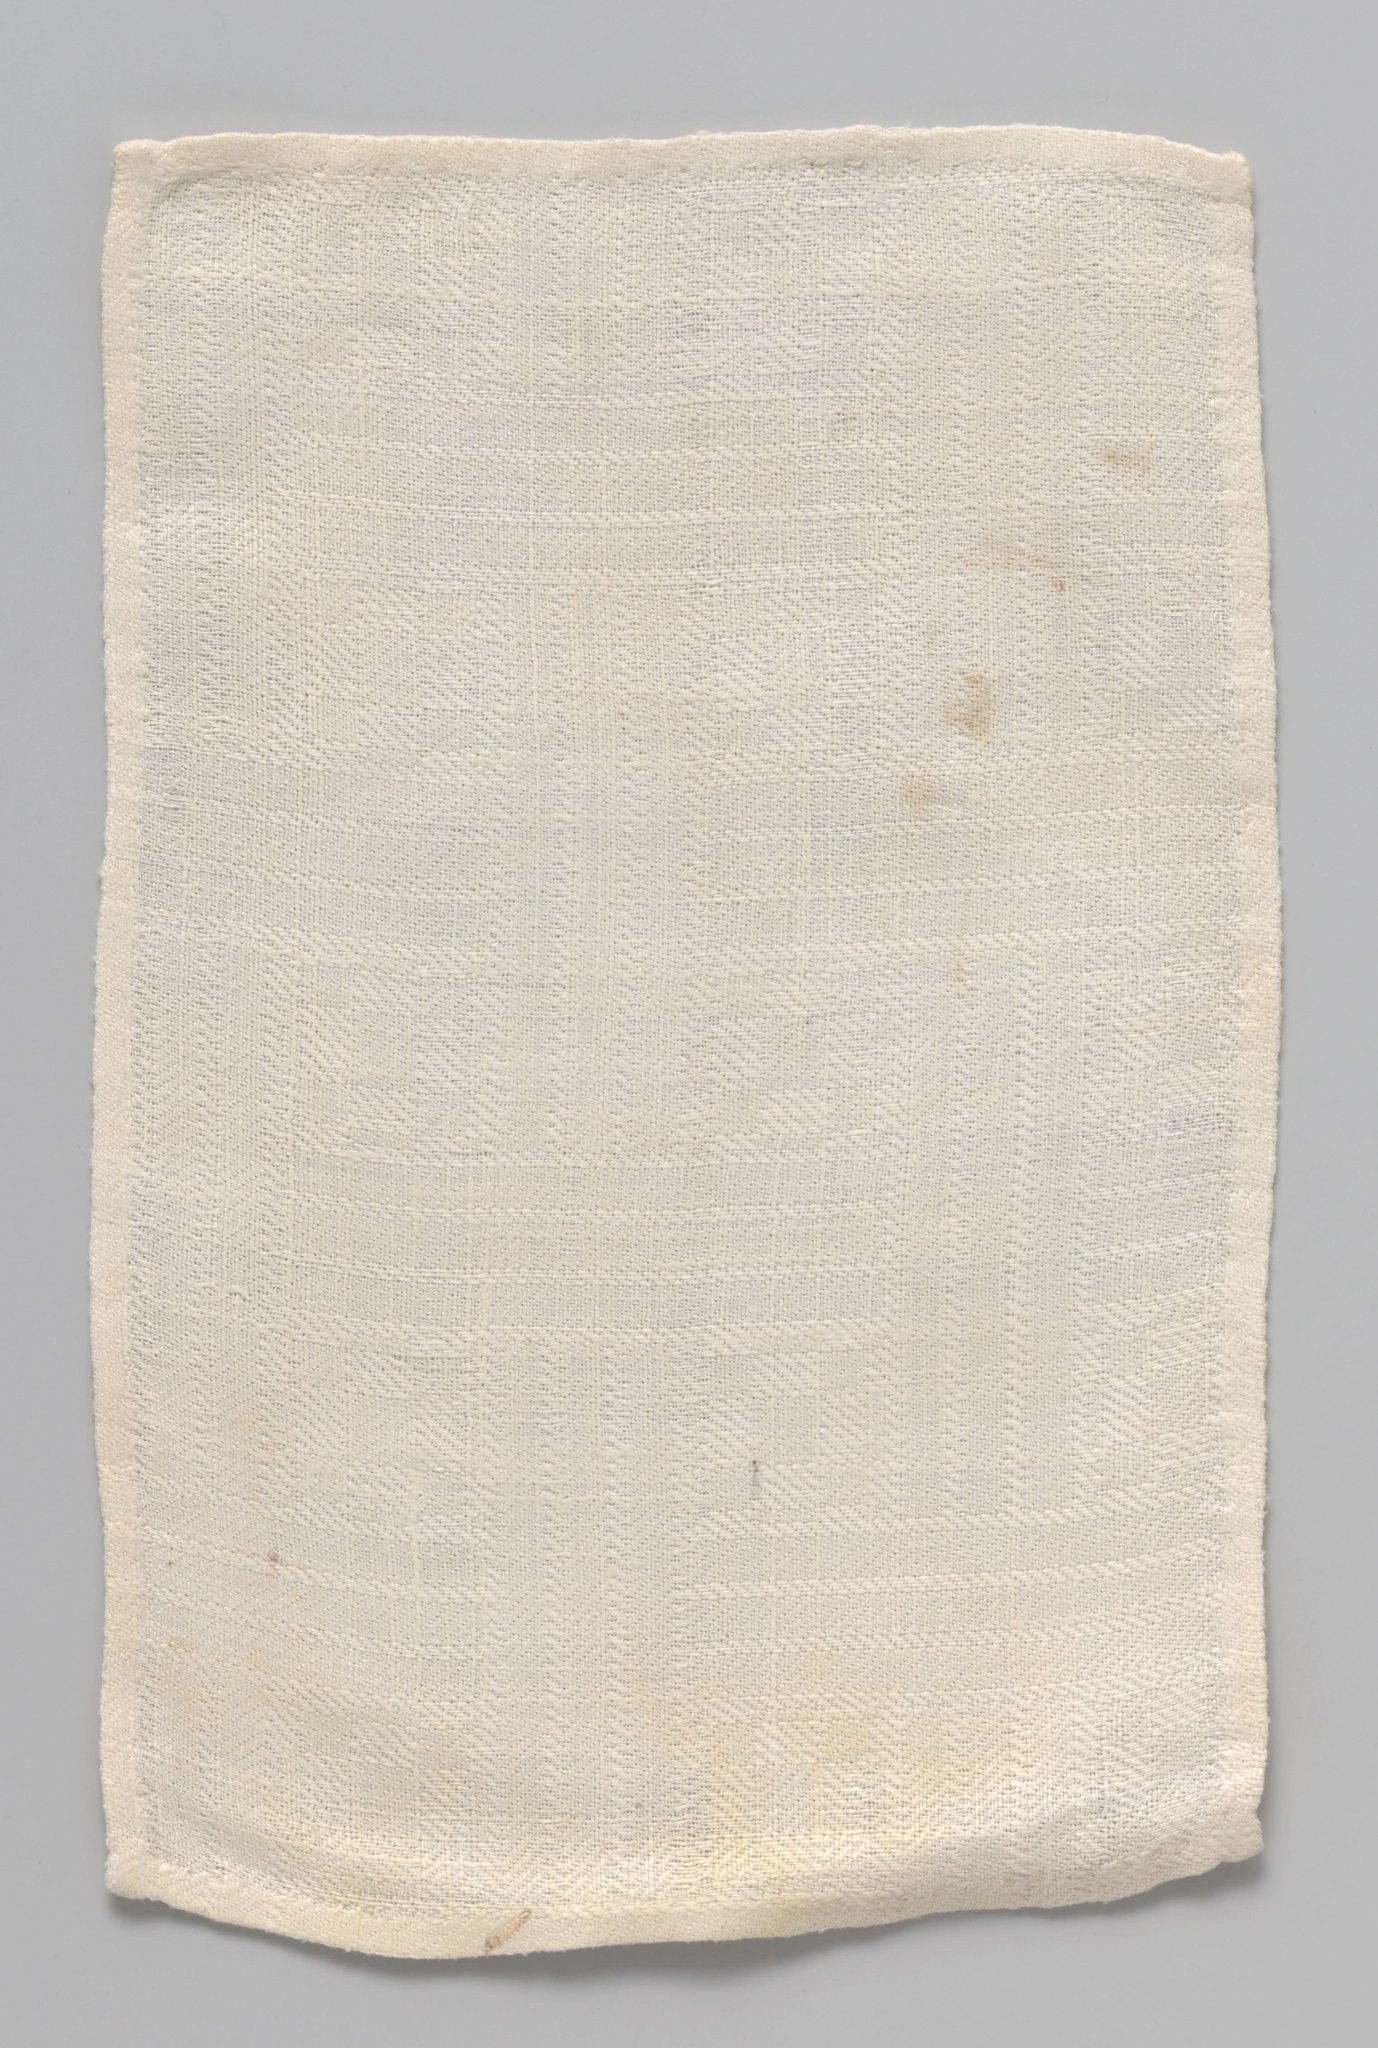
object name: cloth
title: Witte rechthoekige doek met ingeweven geometrisch patroon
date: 1836-1898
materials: textile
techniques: weave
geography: netherlands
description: BK-15446-13 t/m 16 en BK-2021-152 hebben hetzelfde ingeweven geometrische patroon.